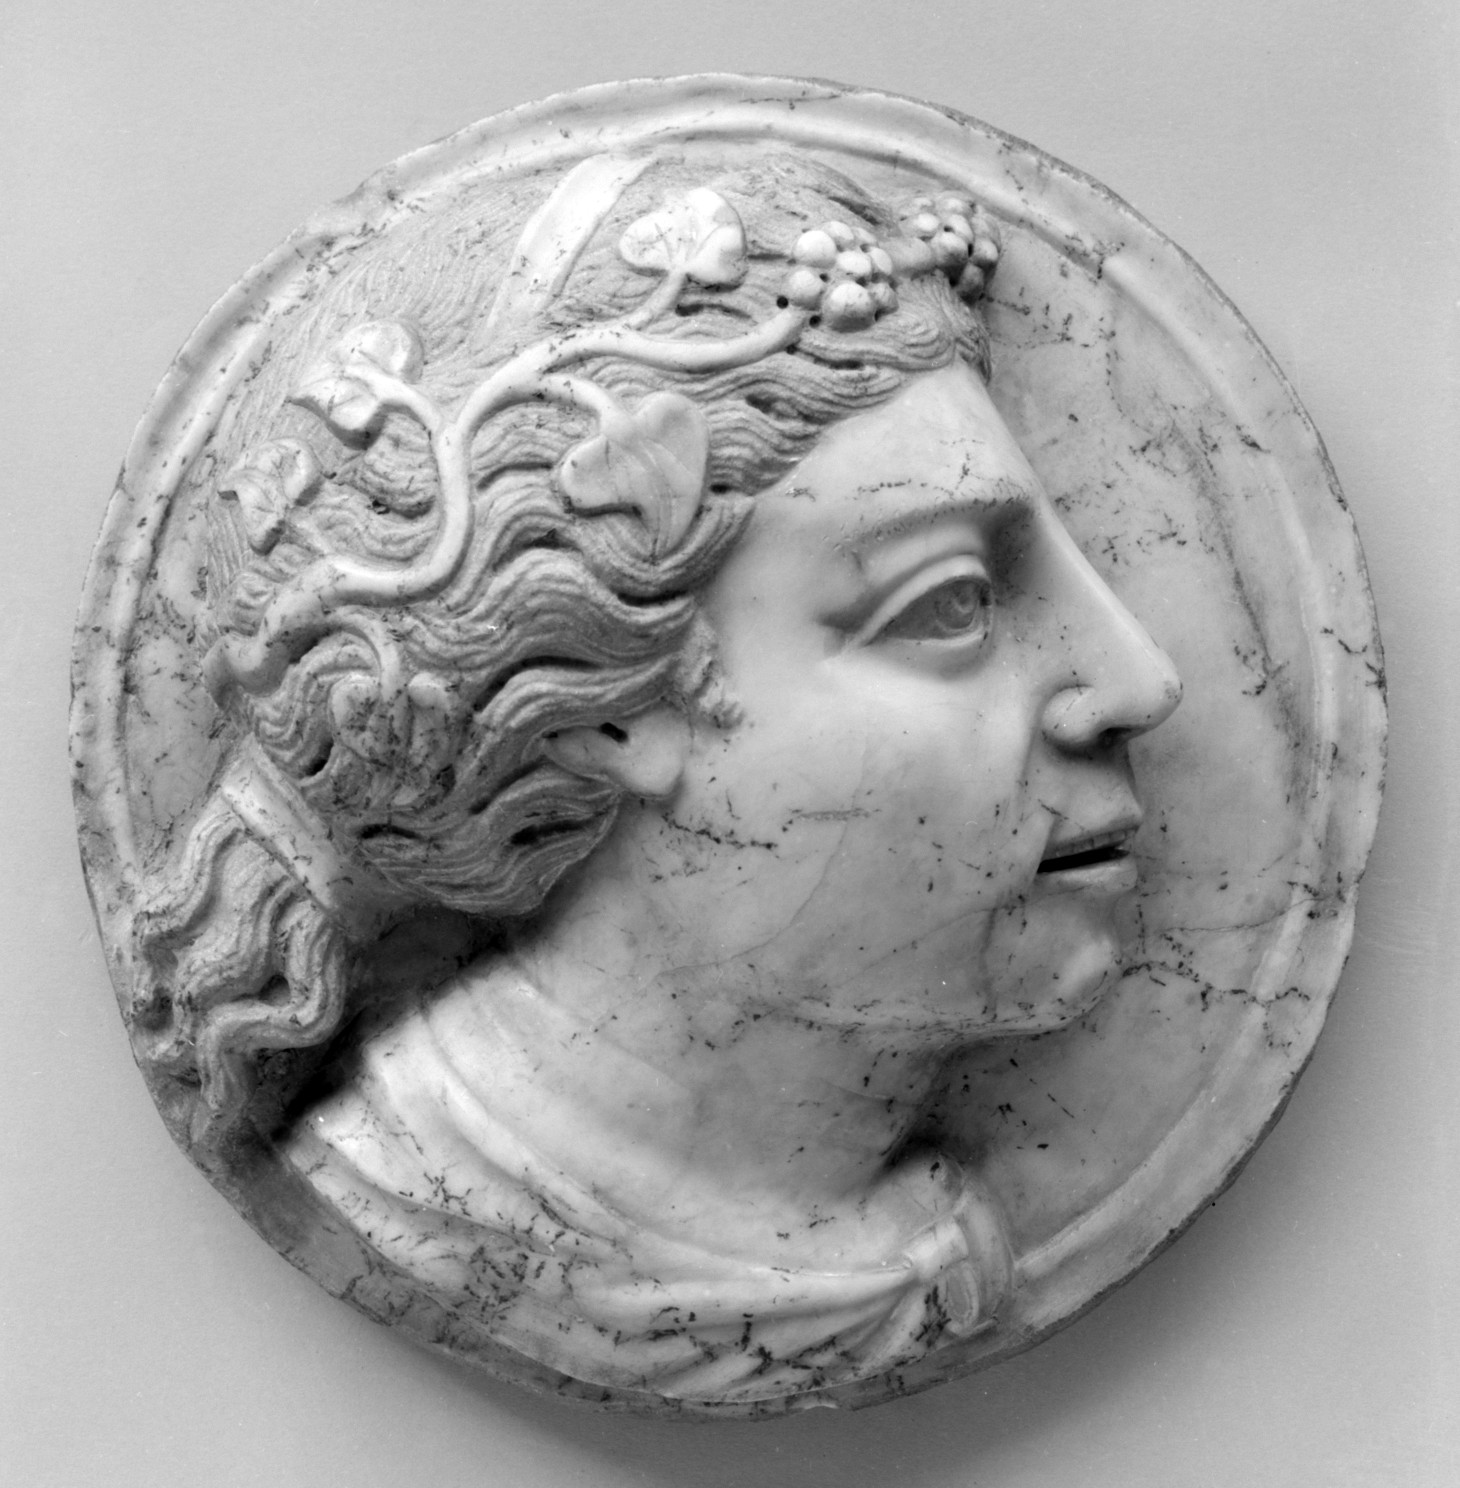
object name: relief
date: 1467-1533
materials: marble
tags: profiles,women